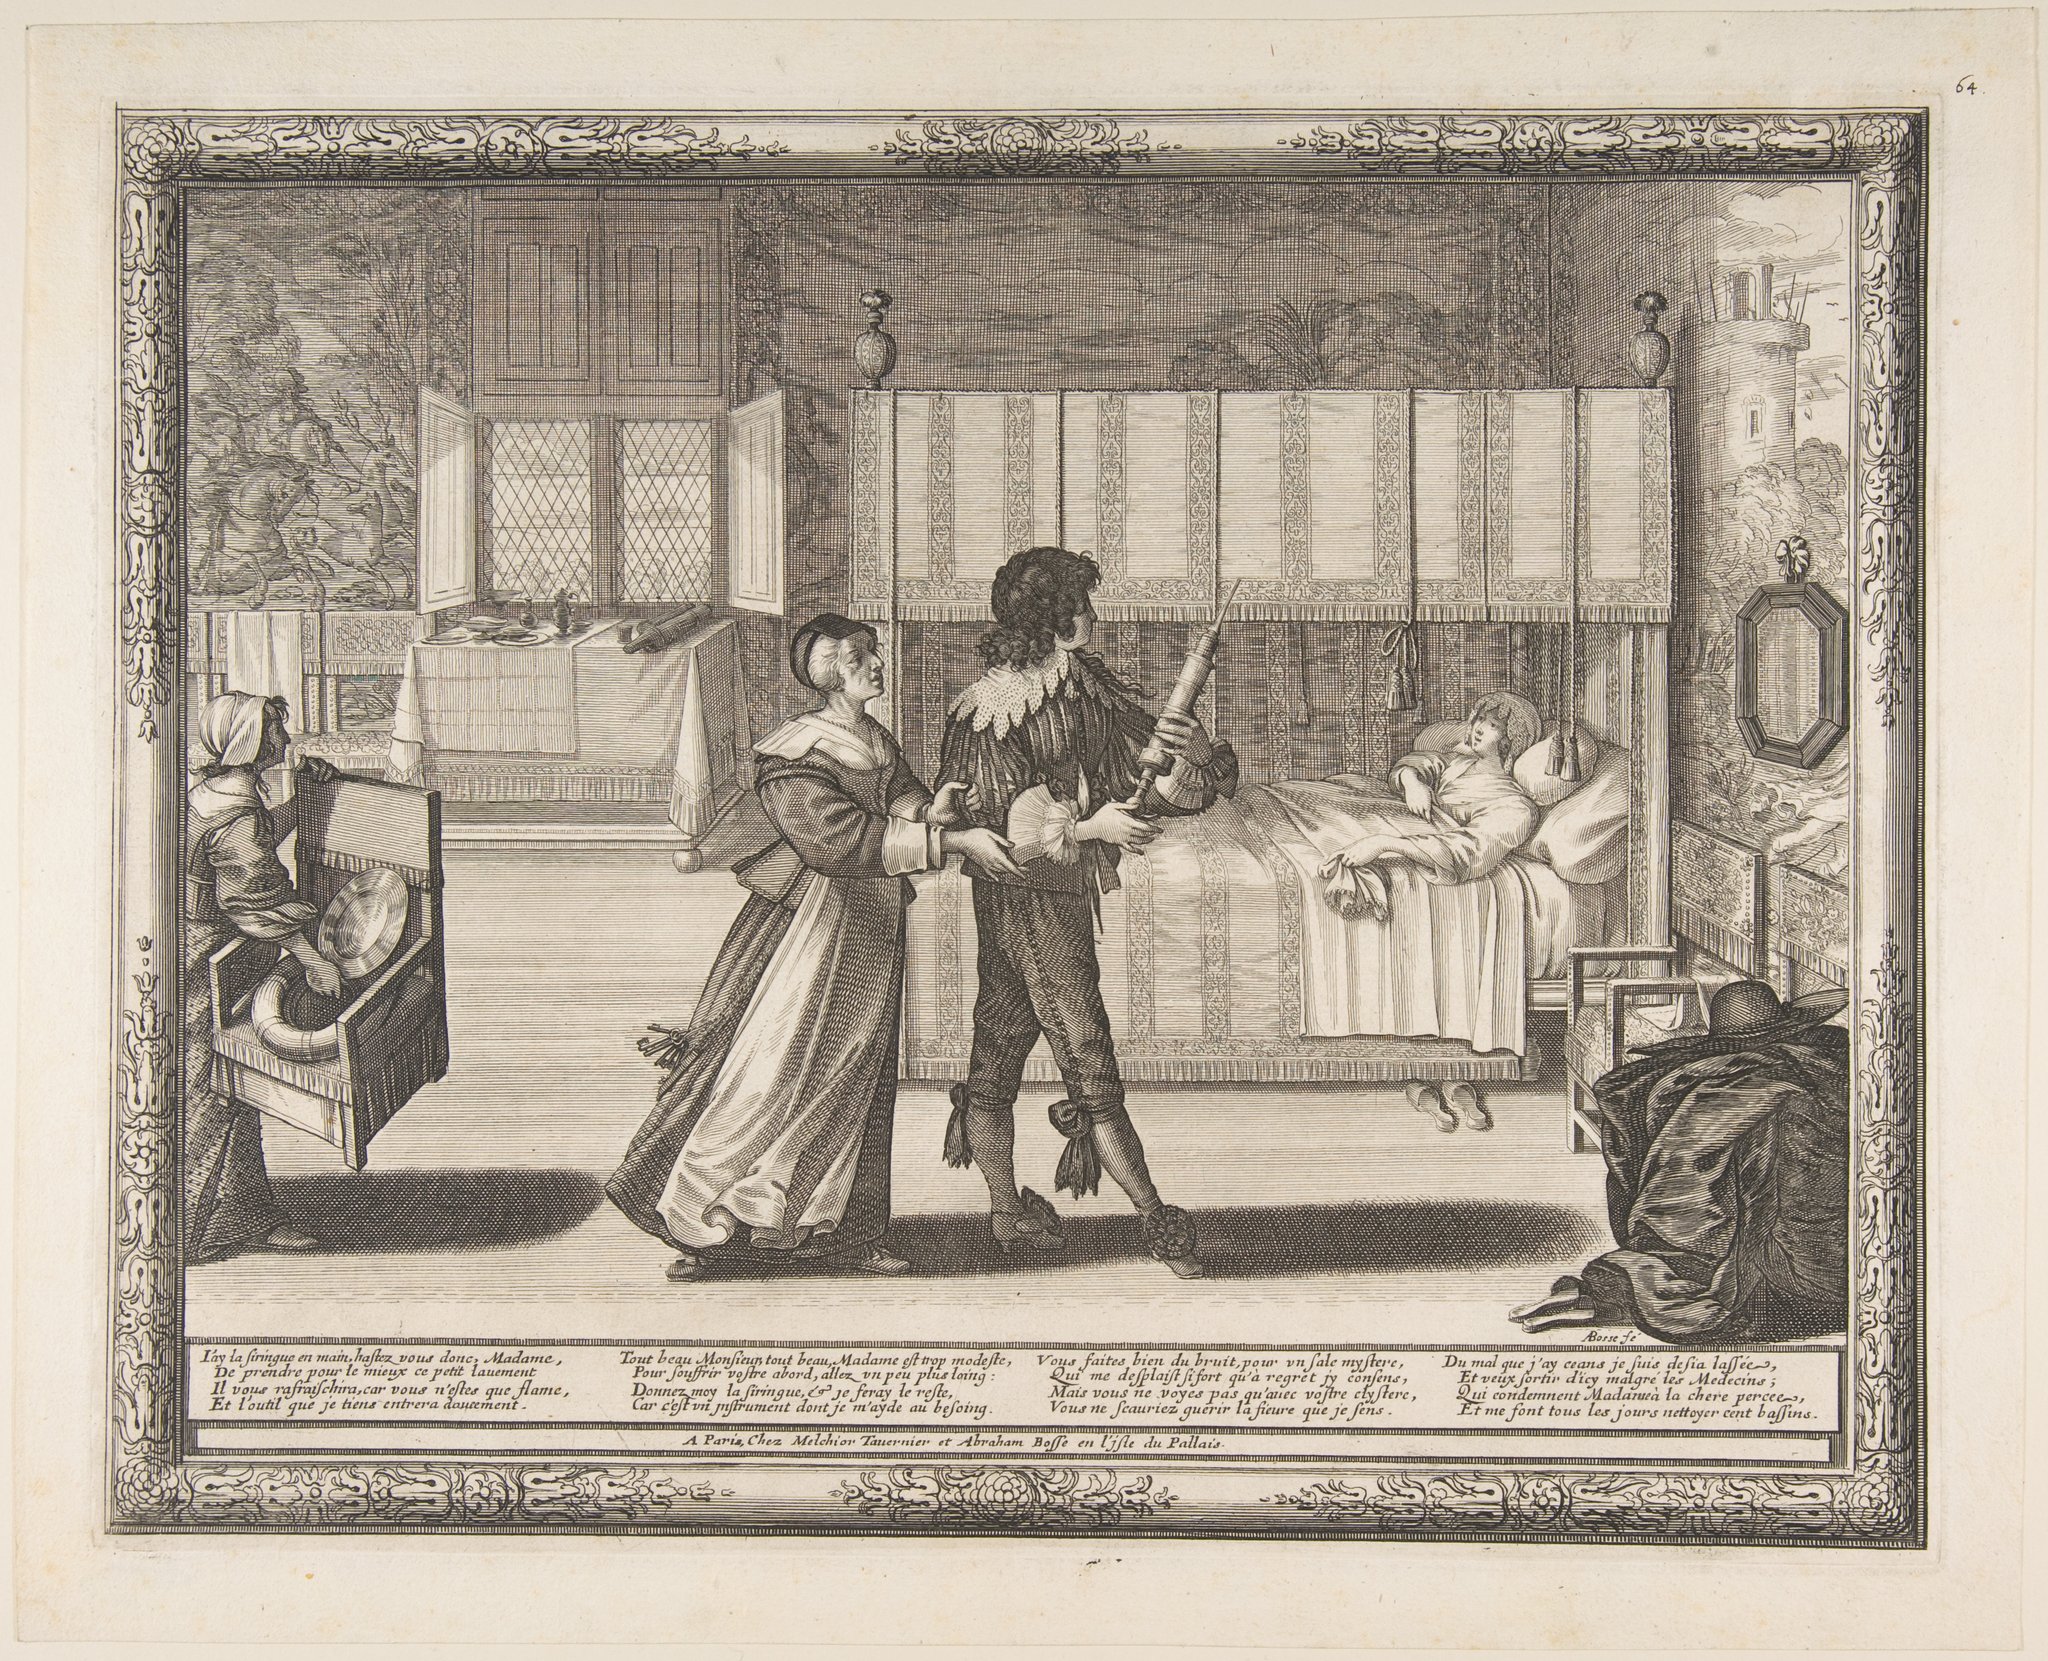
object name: print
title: The Enema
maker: abraham bosse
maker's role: artist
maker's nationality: french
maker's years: 1602-1676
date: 1632-1633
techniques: engraving, etching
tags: bedrooms,illness,men,women